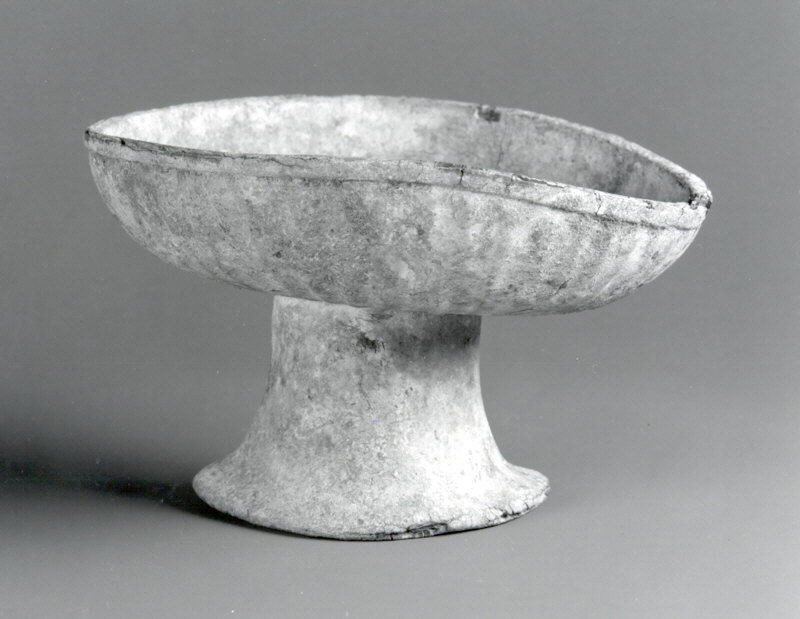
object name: bowl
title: High-footed bowl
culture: sasanian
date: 501-700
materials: pewter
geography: iran